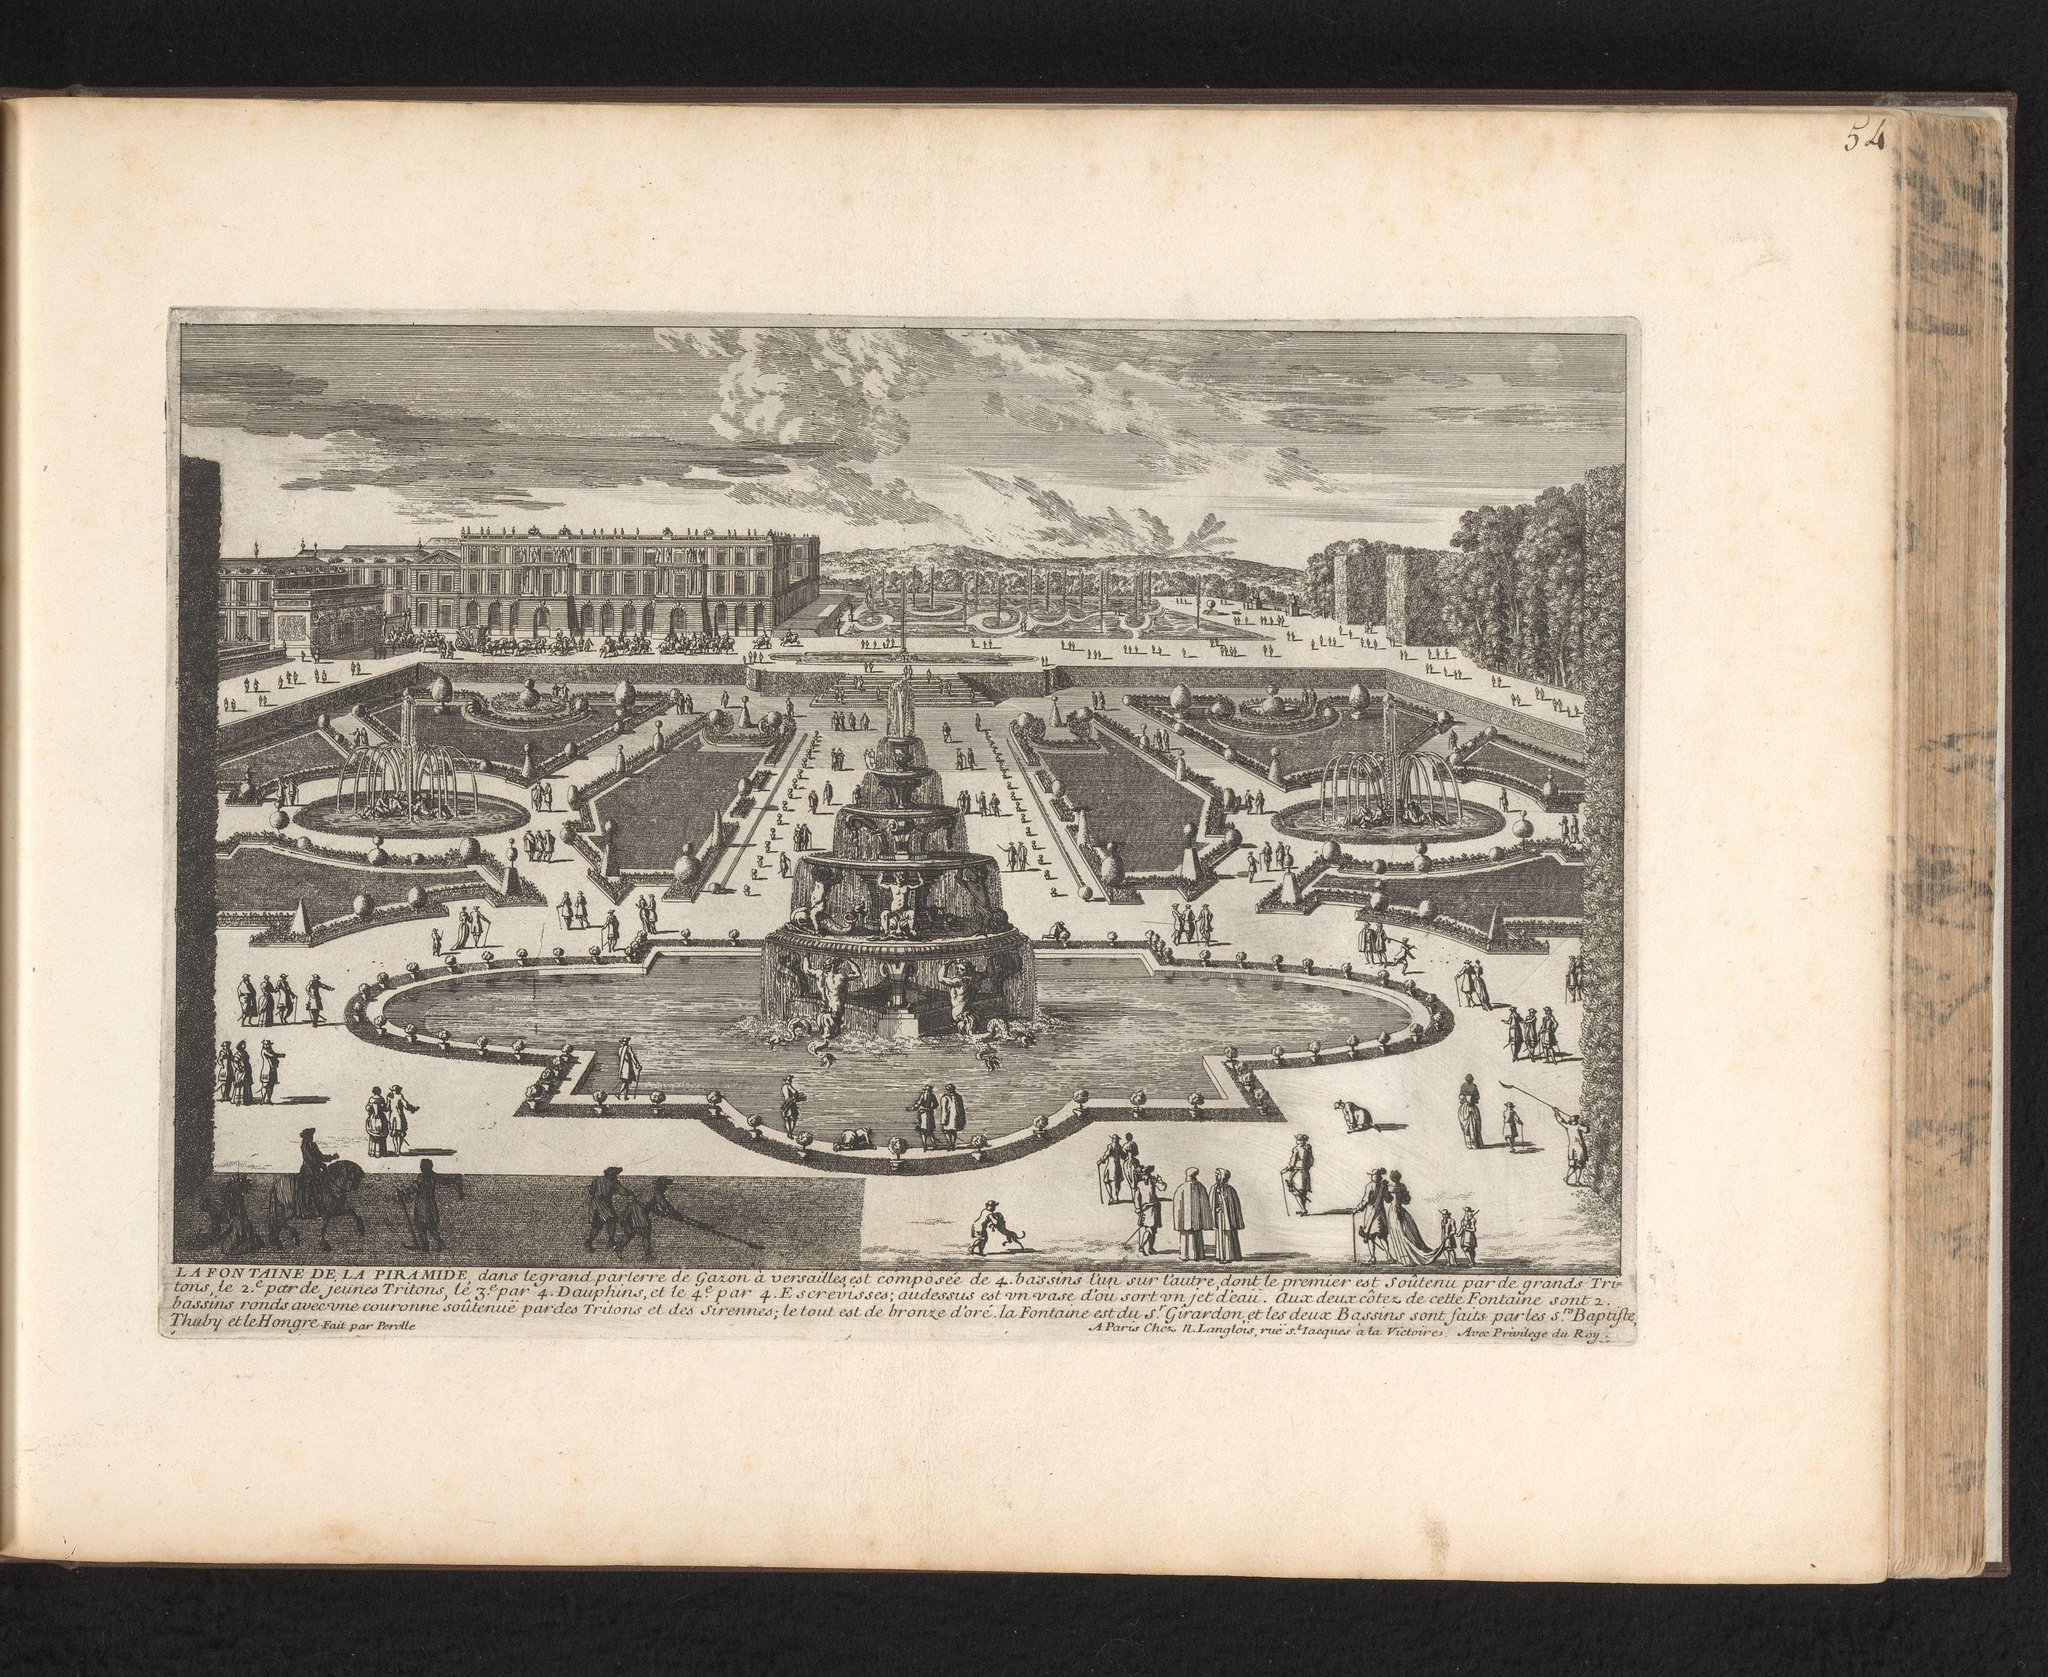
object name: album leaf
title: Recueil de vues de monuments de Paris, des principales résidences royales et des principaux châteaux de France et de Rome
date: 1664-1695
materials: paper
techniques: etching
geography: france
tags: triton(s), garden fountain, french or architectonic garden; formal garden, landscape with tower or castle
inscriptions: collector's mark: Lugt 2228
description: Prenten met het signatuur 'Perelle' kunnen zowel door vader Gabriel als door zonen Nicolas en Adam gemaakt zijn. De uitgevers vader en zoon Nicolas Langlois worden allebei vermeld als N. Langlois op hetzelfde adres.